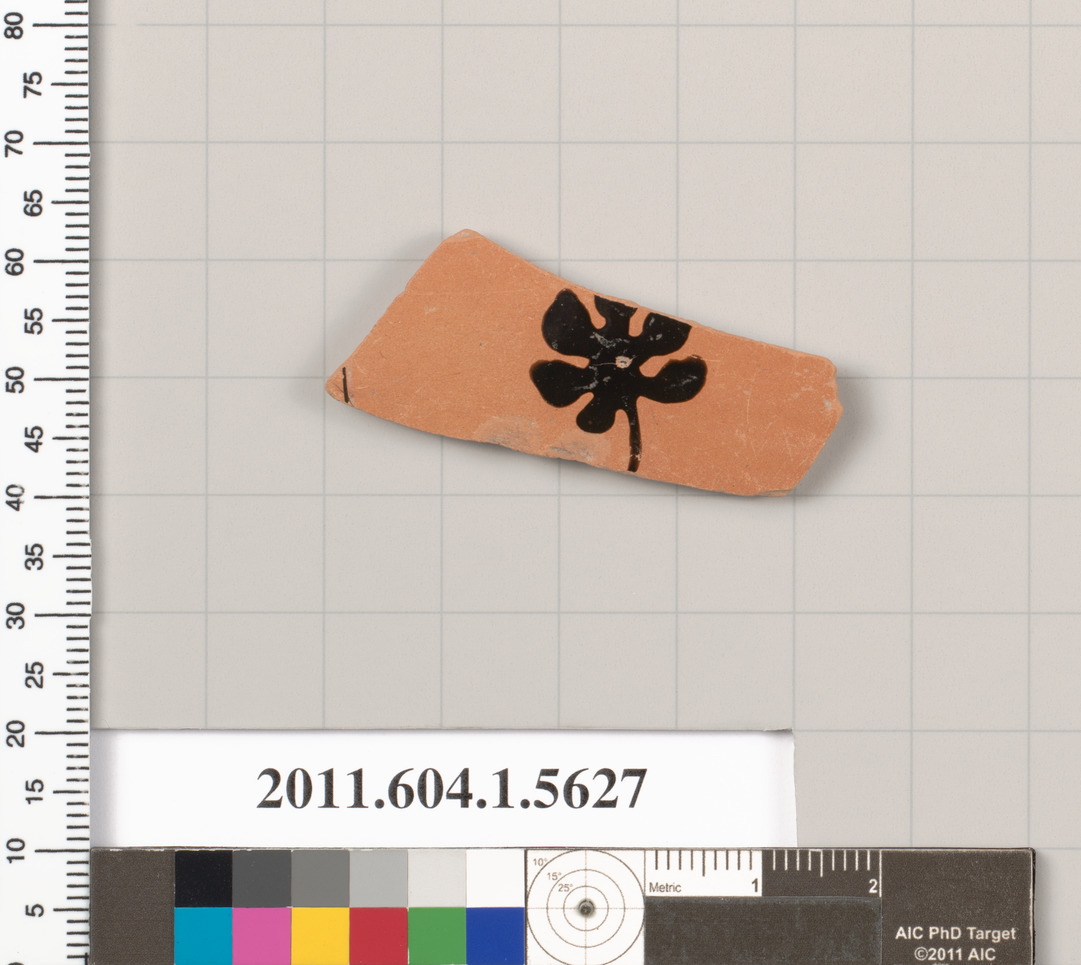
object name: kylix fragment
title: Terracotta fragment of a kylix (drinking cup)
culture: greek, attic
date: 520-500 BCE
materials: terracotta